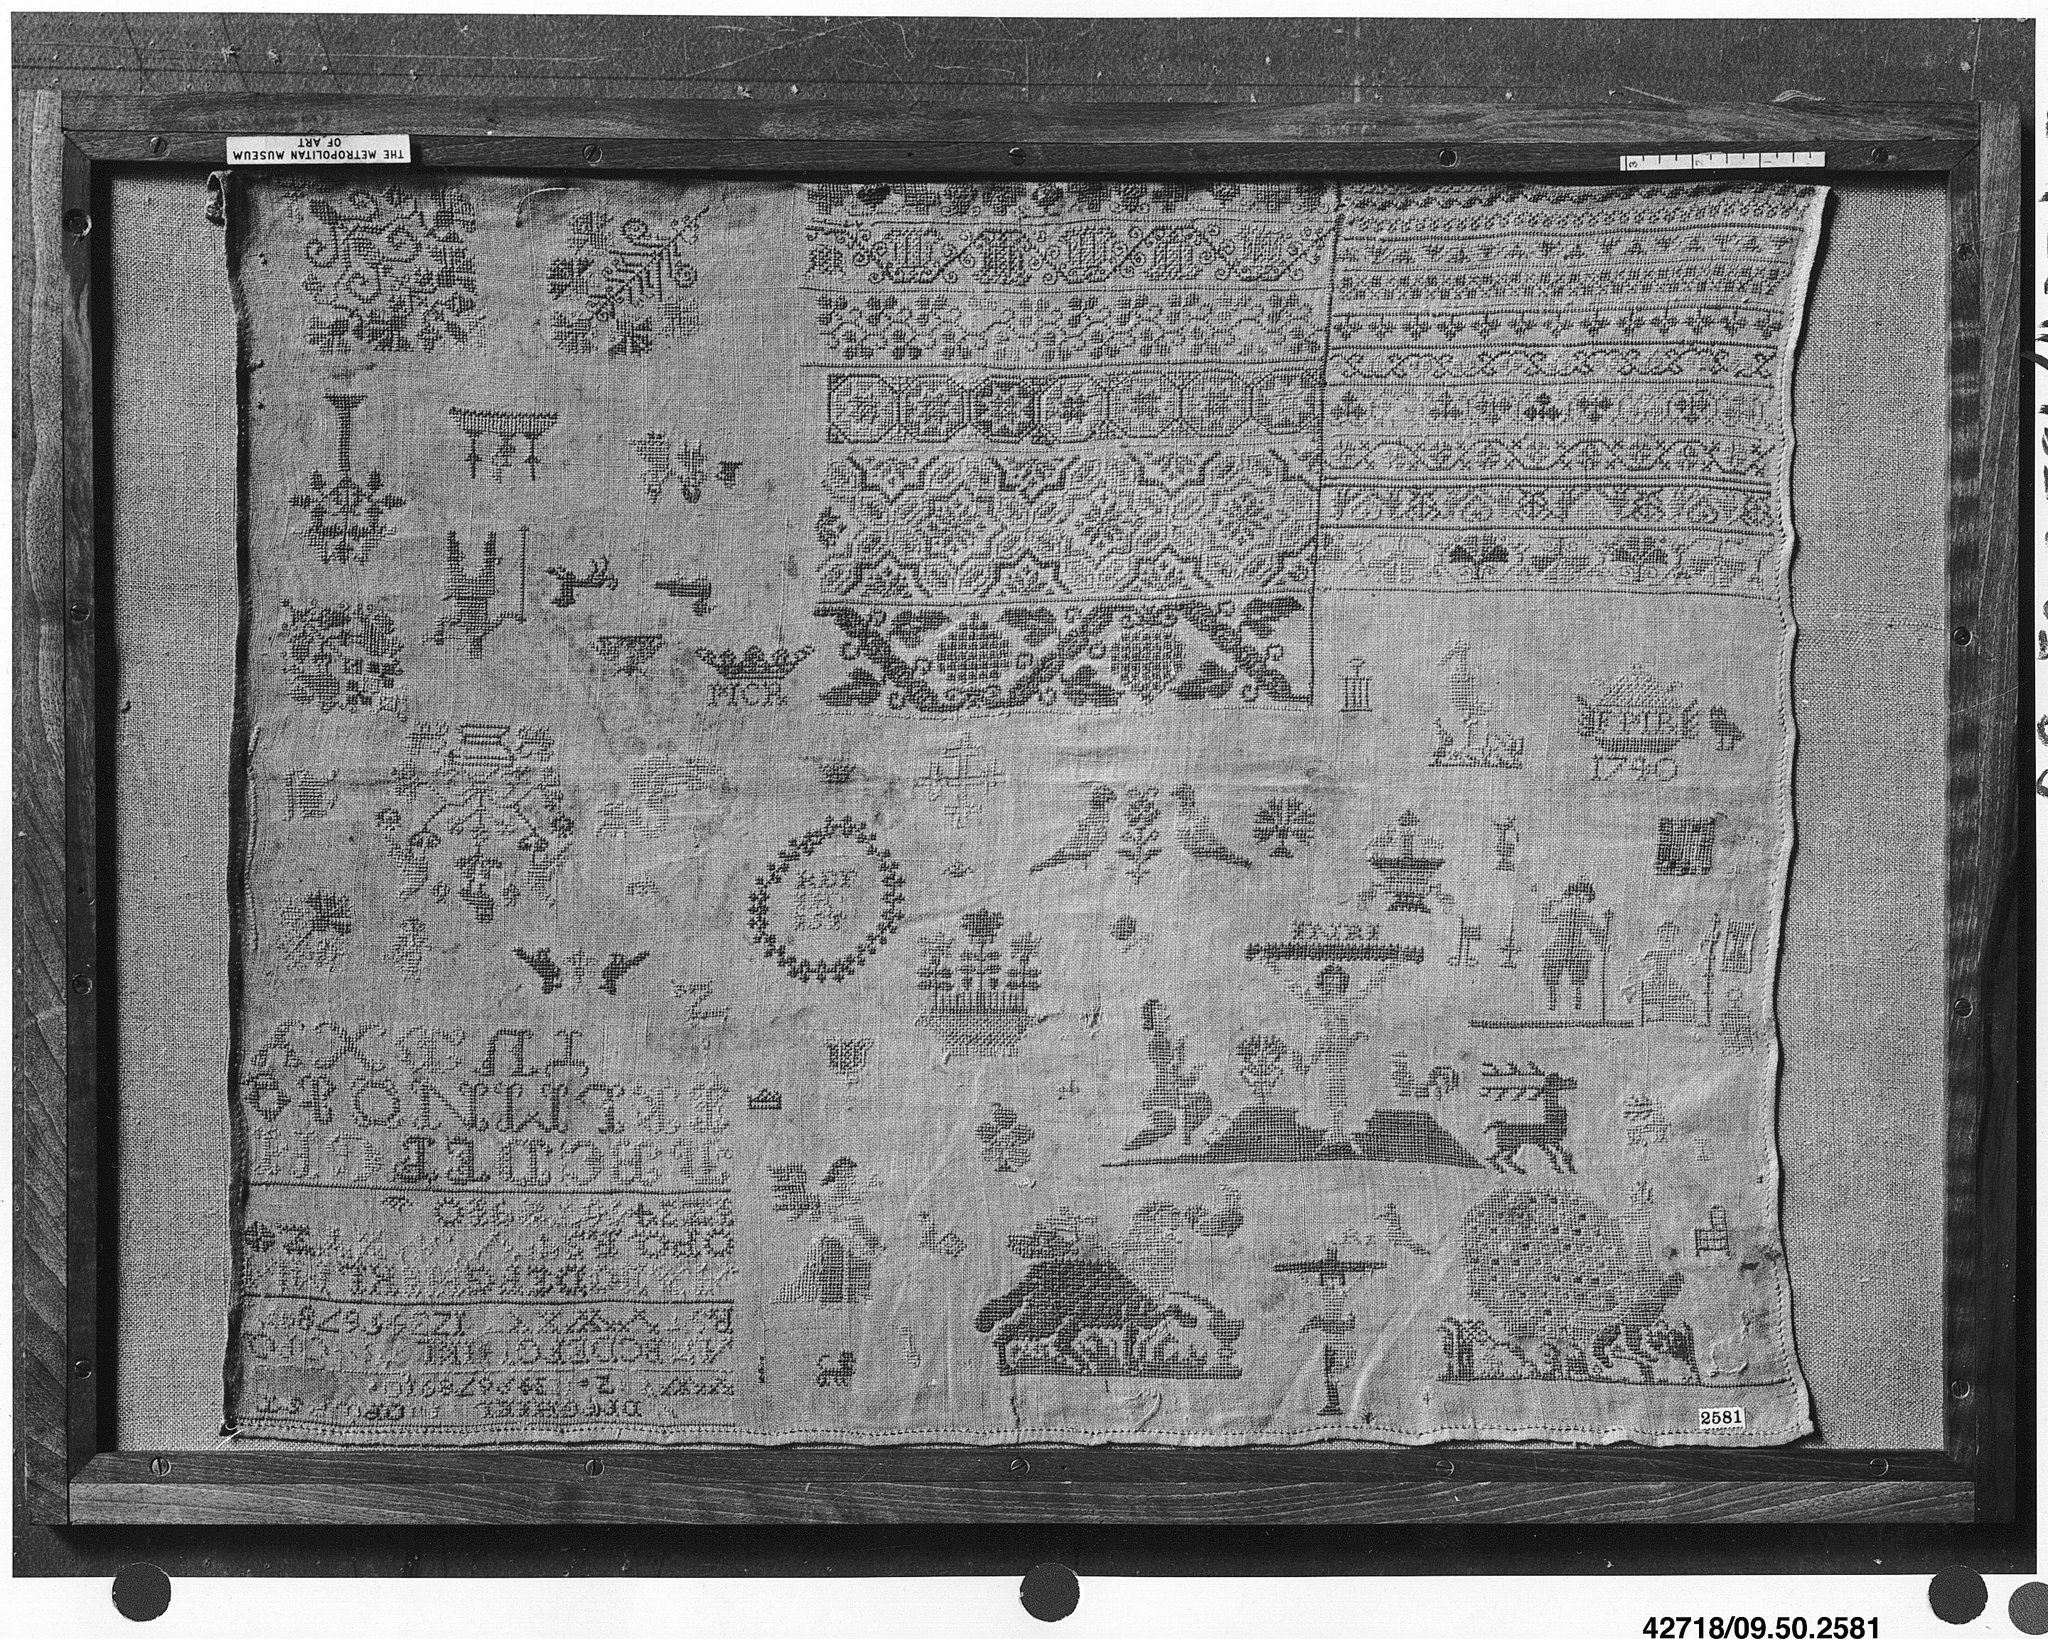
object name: sampler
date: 1740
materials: linen, silk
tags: human figures,birds